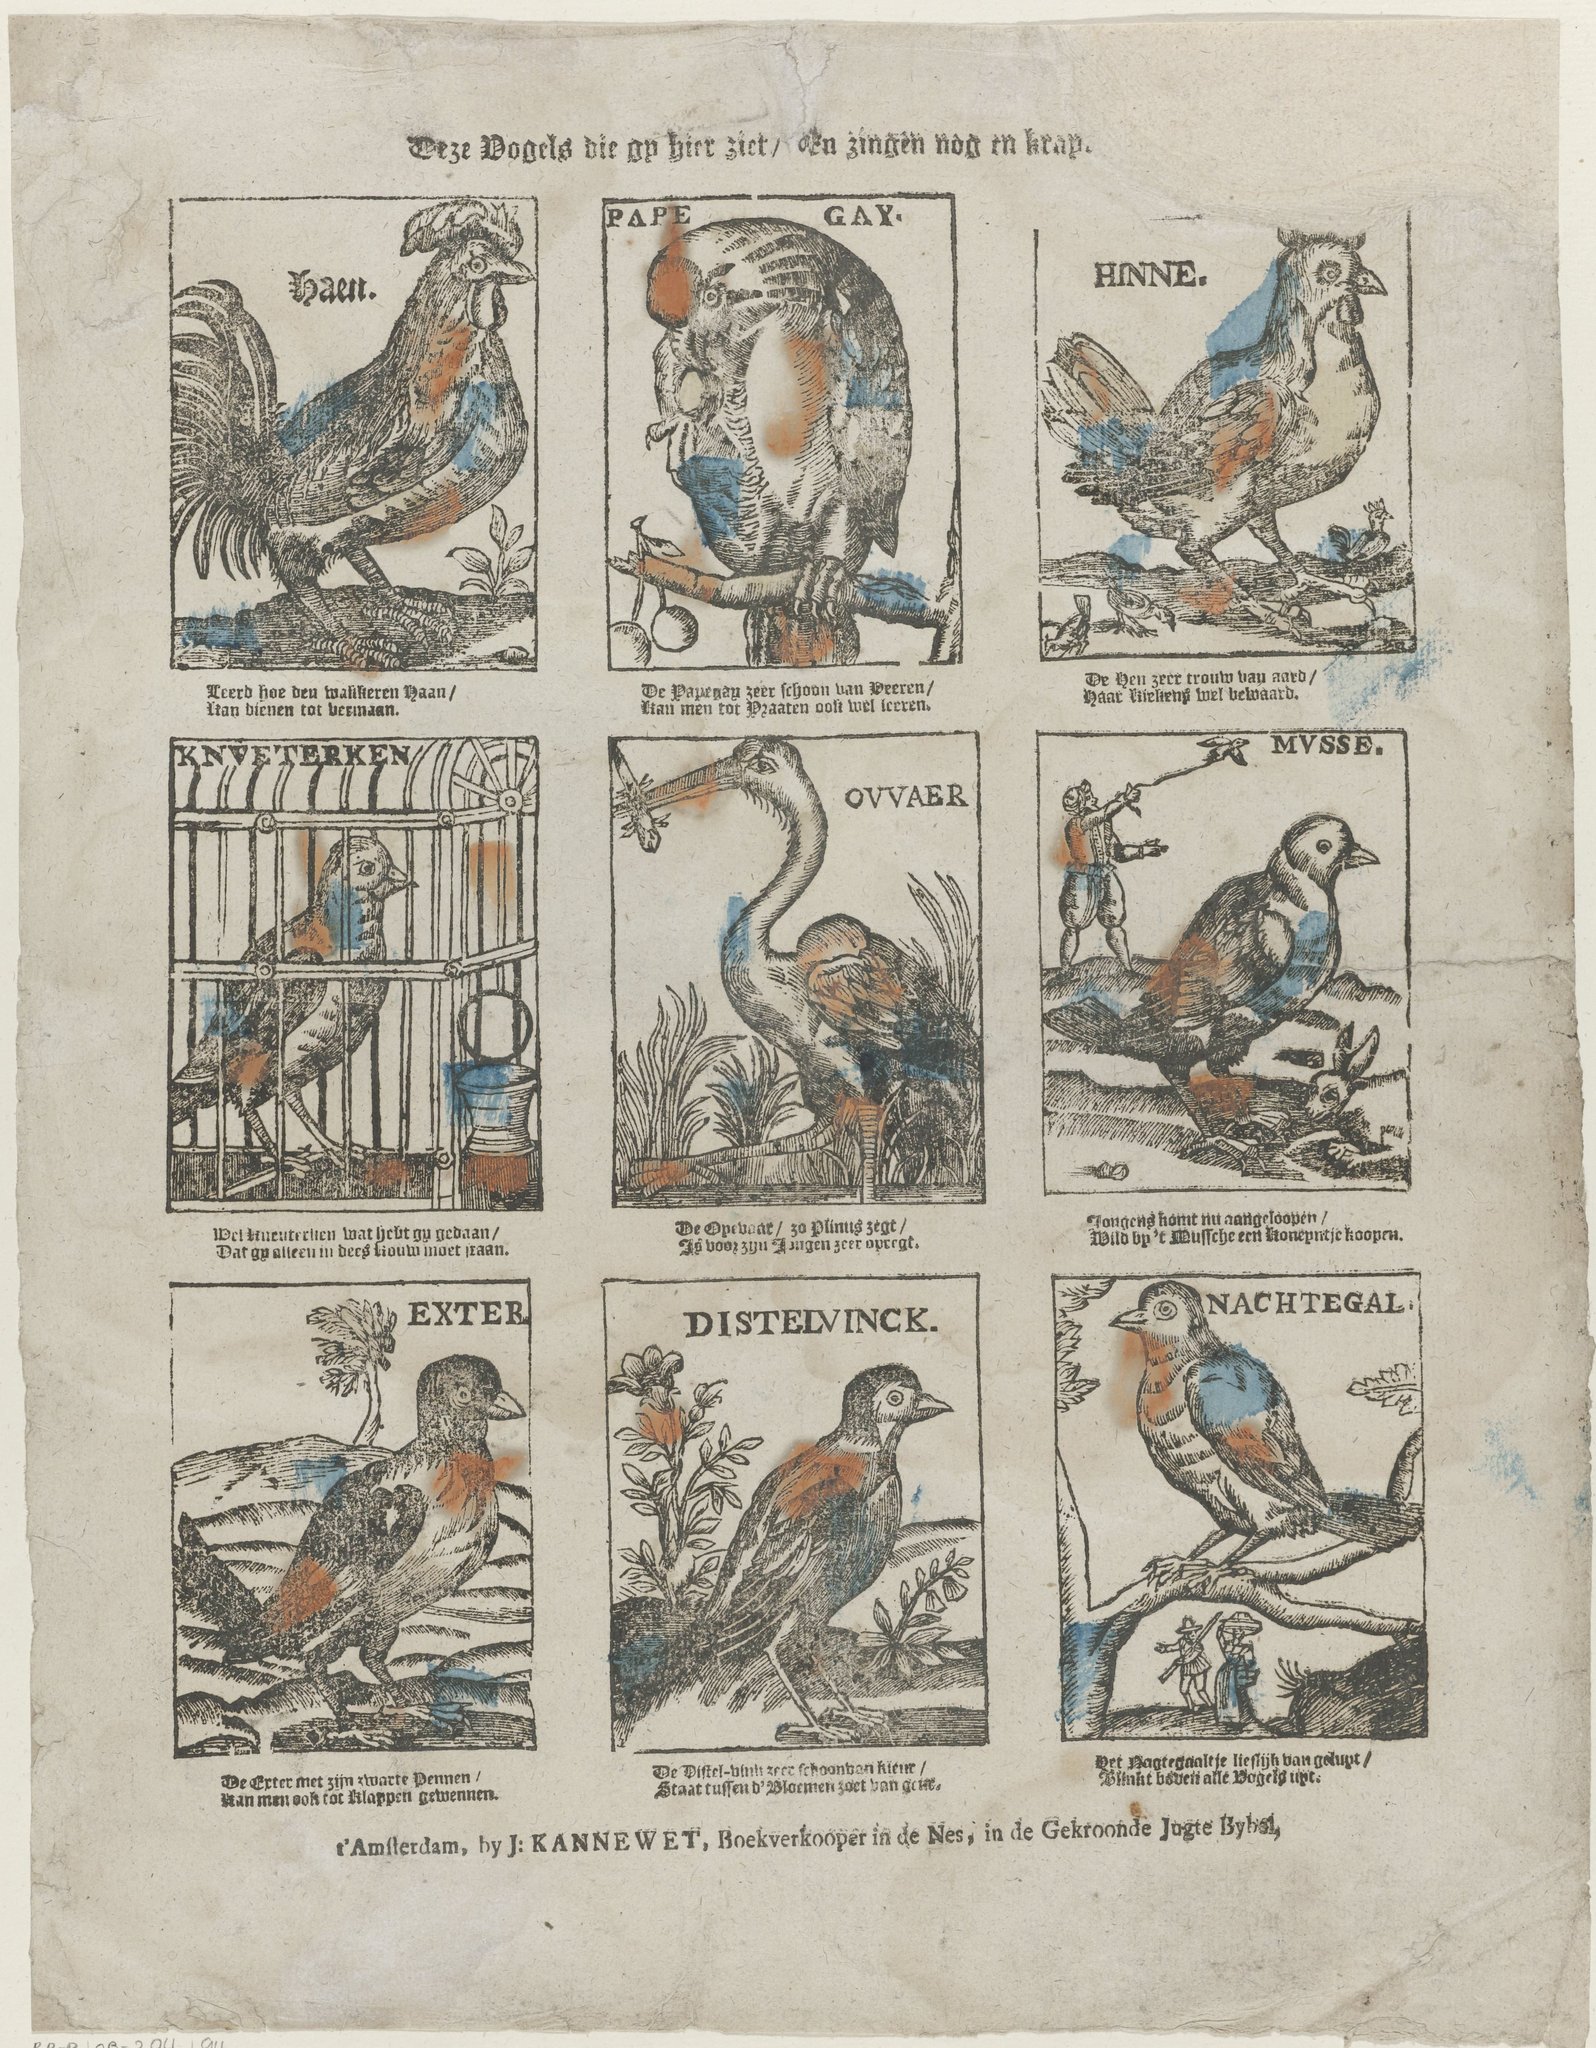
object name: print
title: Deze vogels die gy op hier ziet / En zingen nog en kray[en niet]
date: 1725-1780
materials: paper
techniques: colour, letterpress printing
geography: amsterdam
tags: birds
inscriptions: collector's mark: Lugt 2760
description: Blad met 9 voorstellingen van vogels, zoals een haan, een papegaai en een ekster. Onder elke afbeelding een tweeregelig vers.